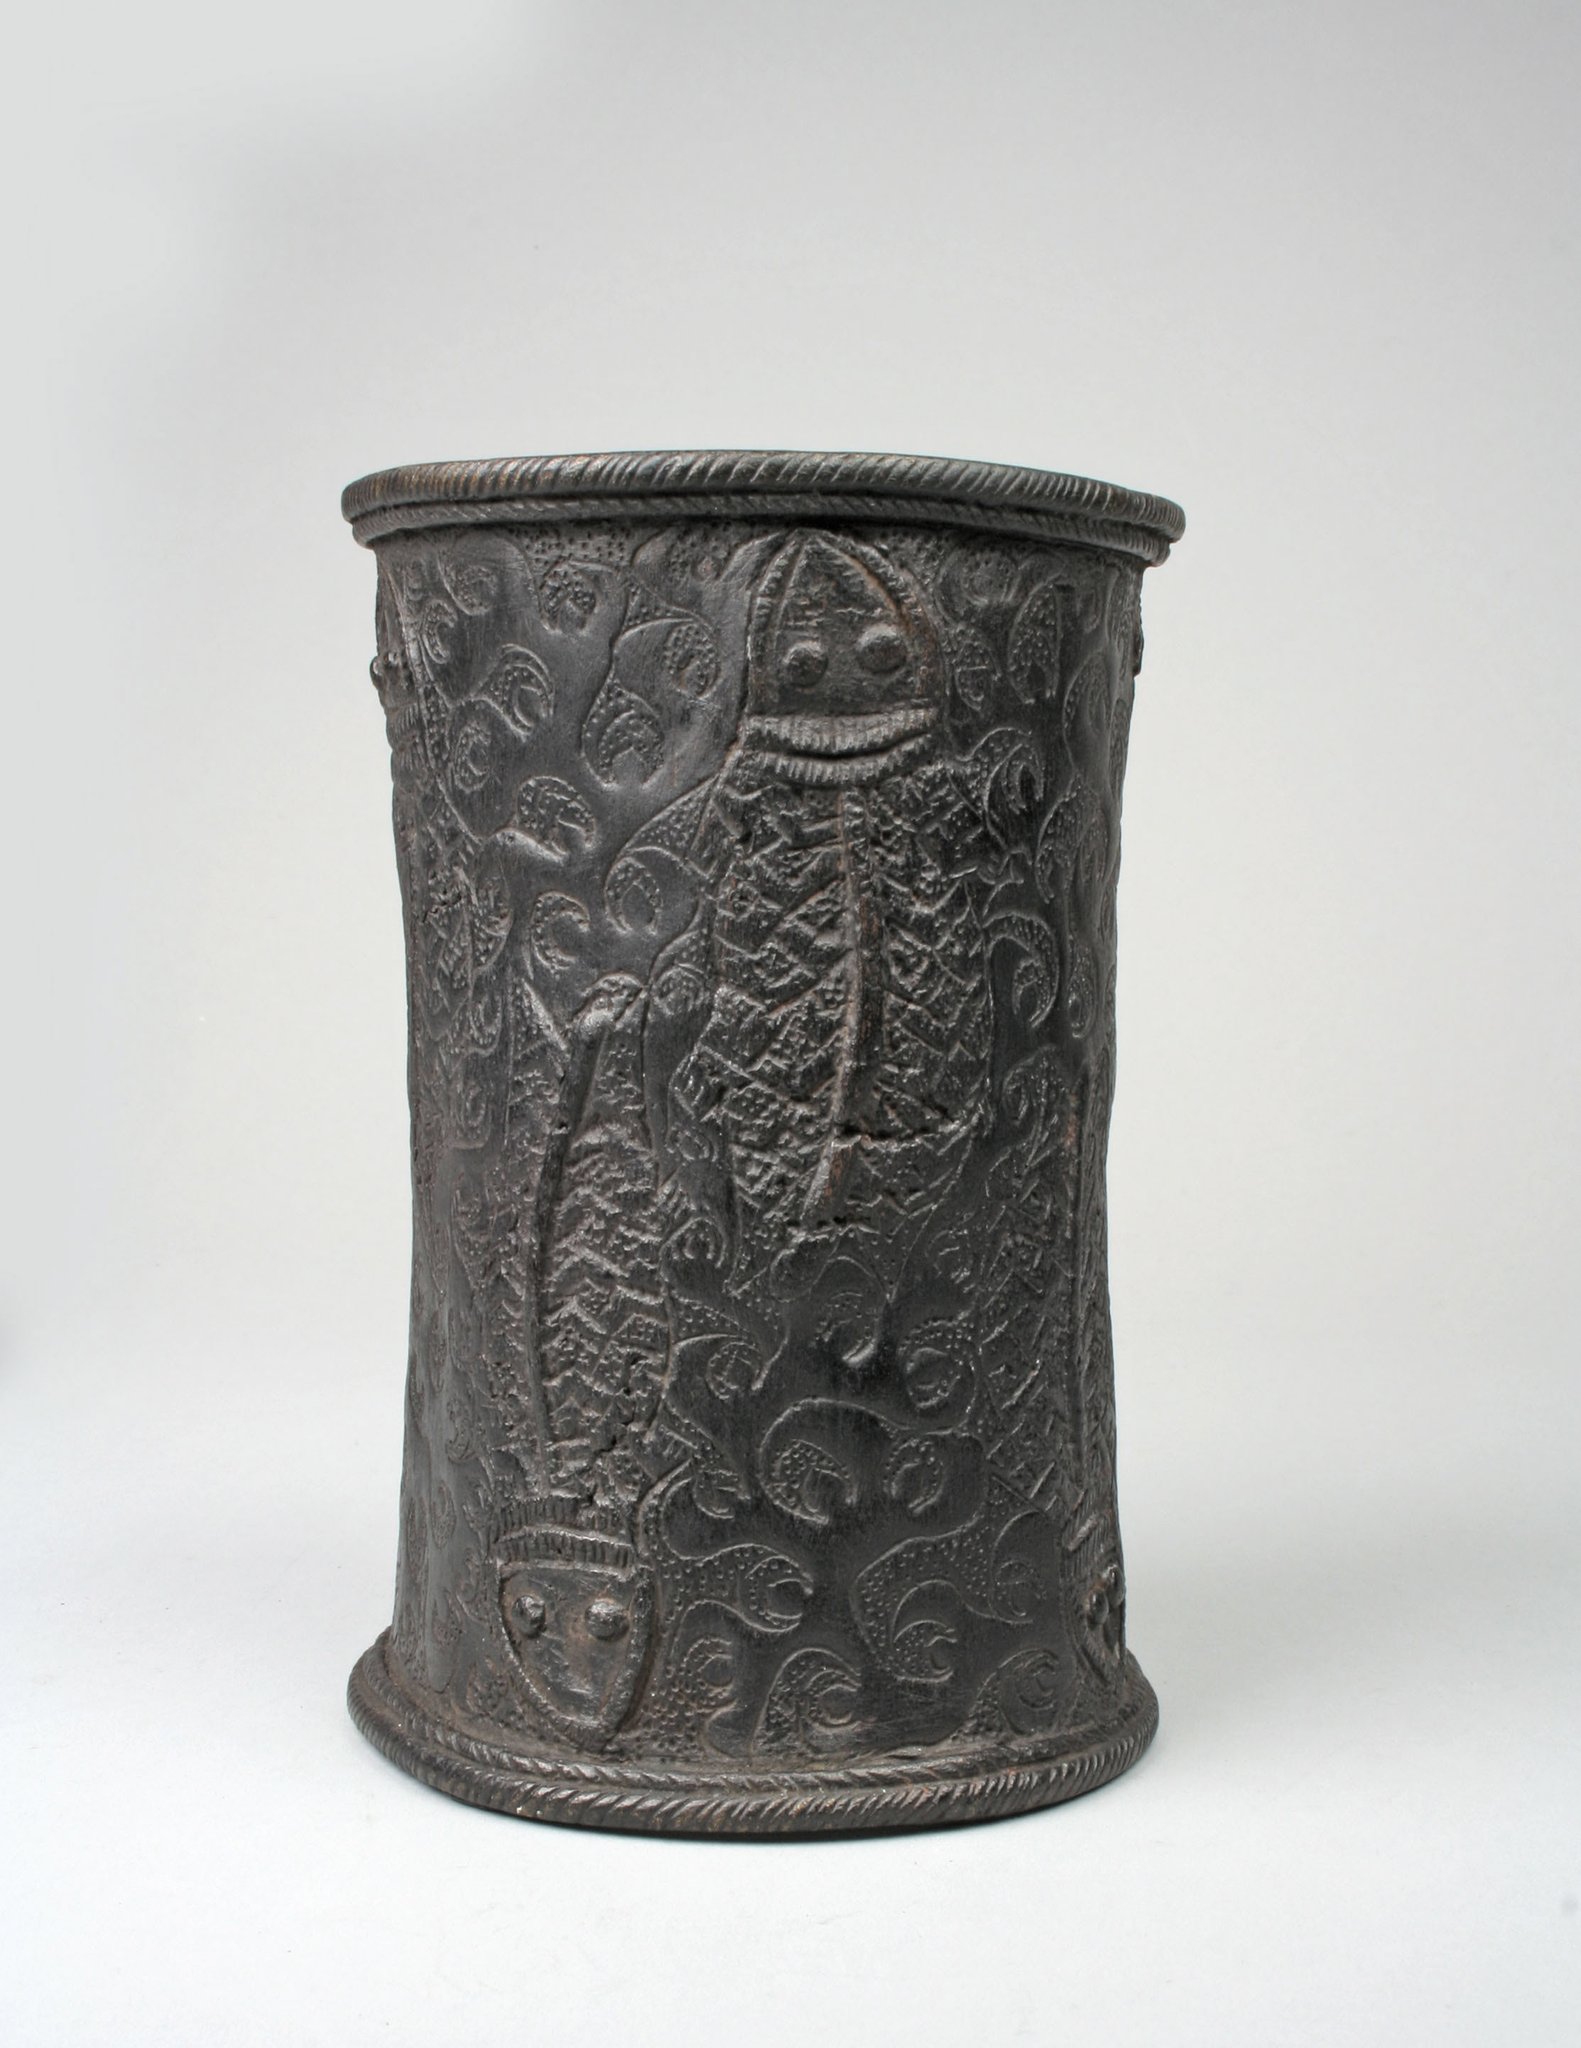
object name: bracelet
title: Bracelet: Mudfish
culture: edo period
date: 1501-1900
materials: brass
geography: nigeria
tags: fish